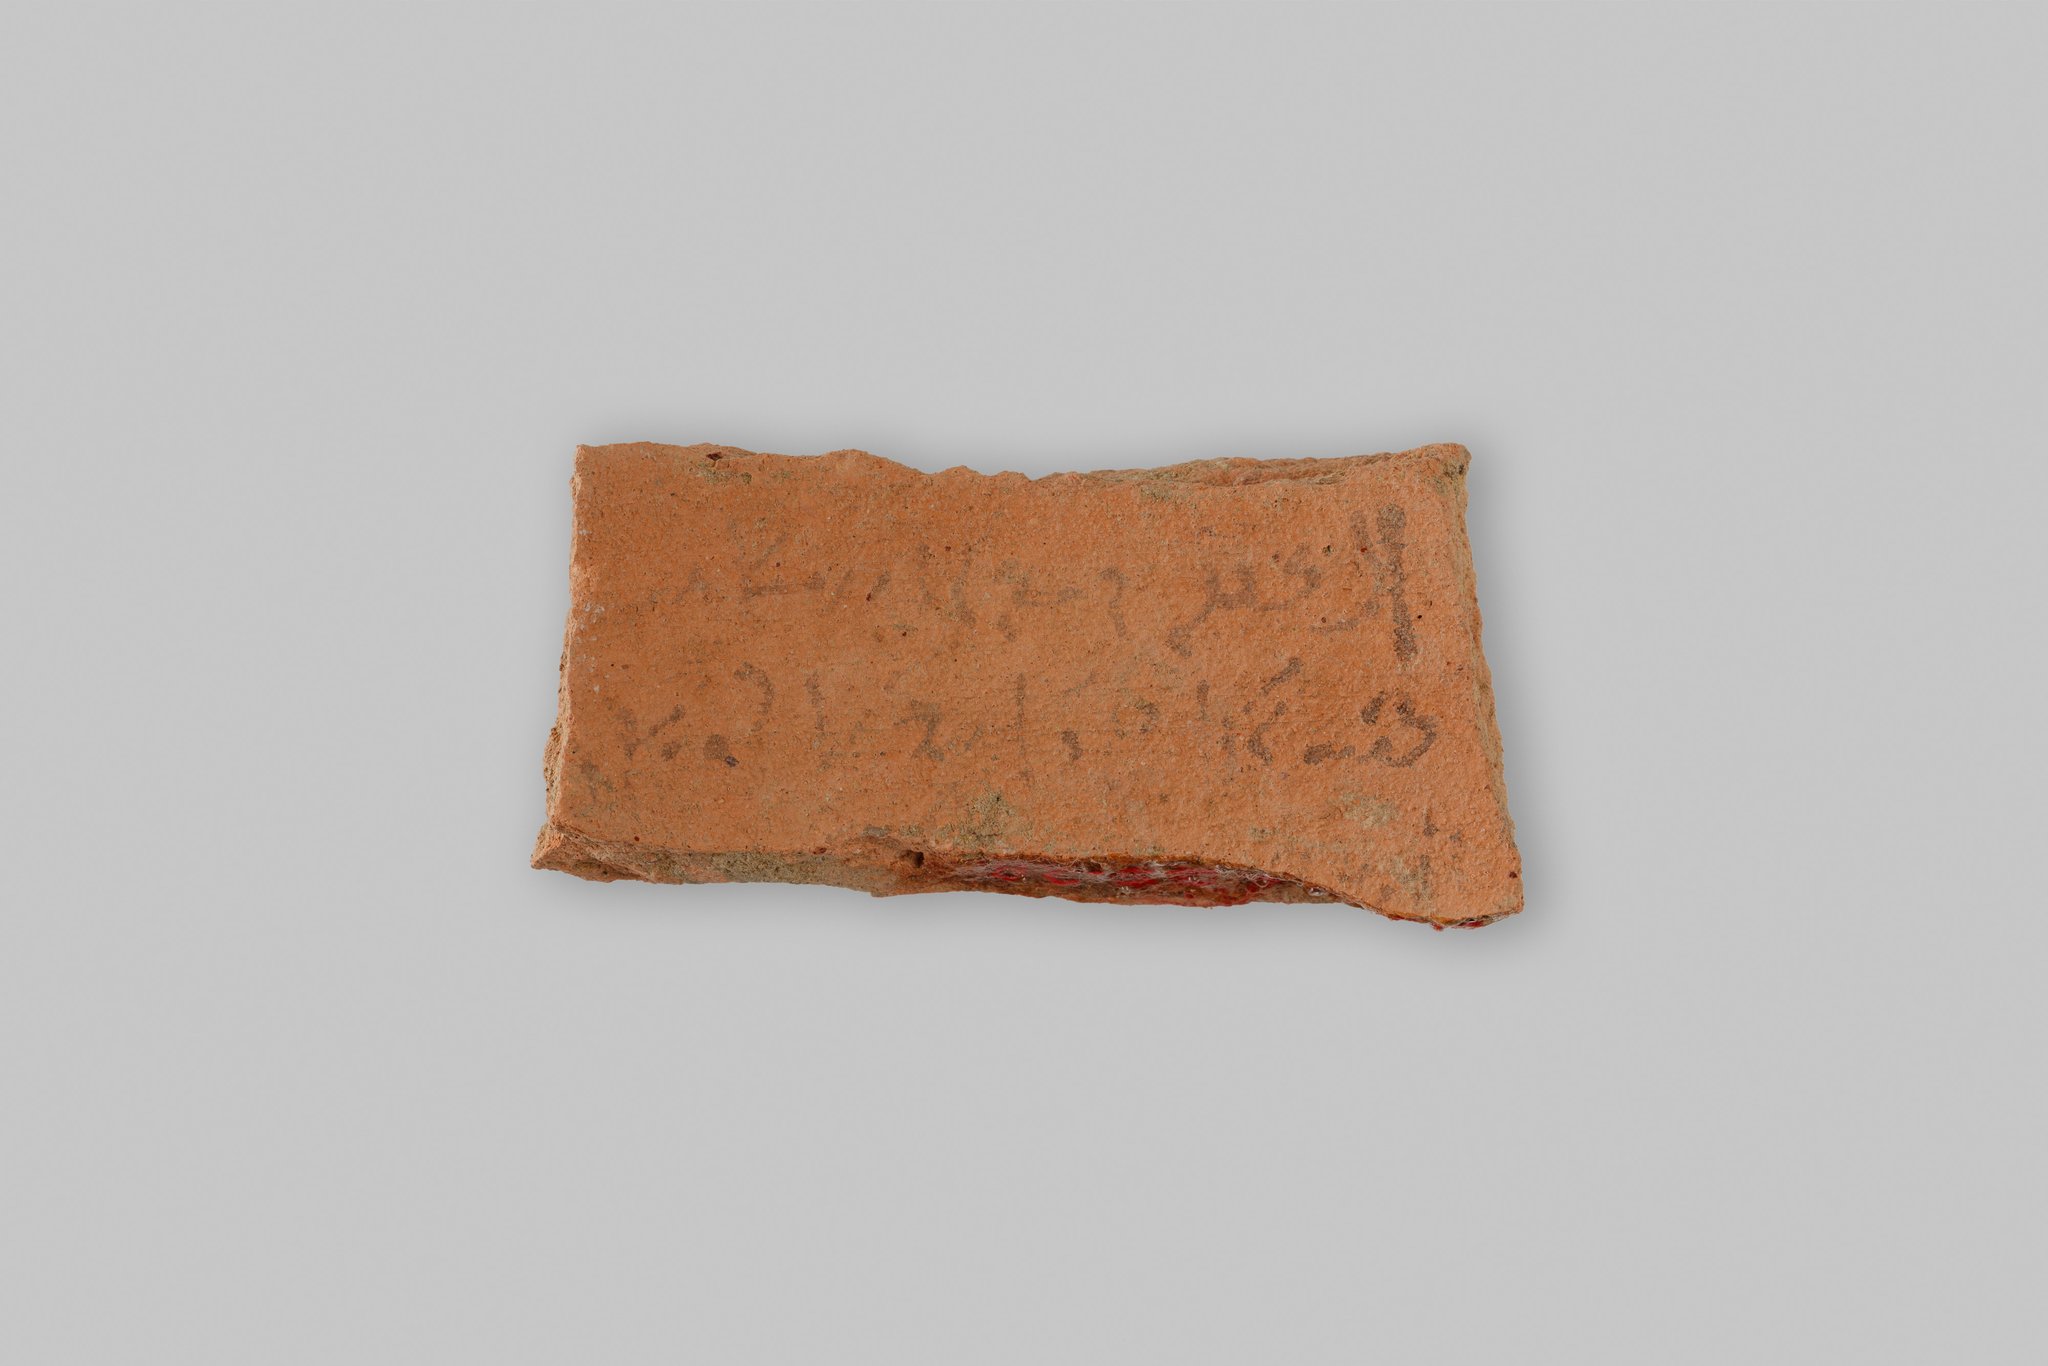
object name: ostracon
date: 400-30 BCE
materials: ink, pottery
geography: egypt